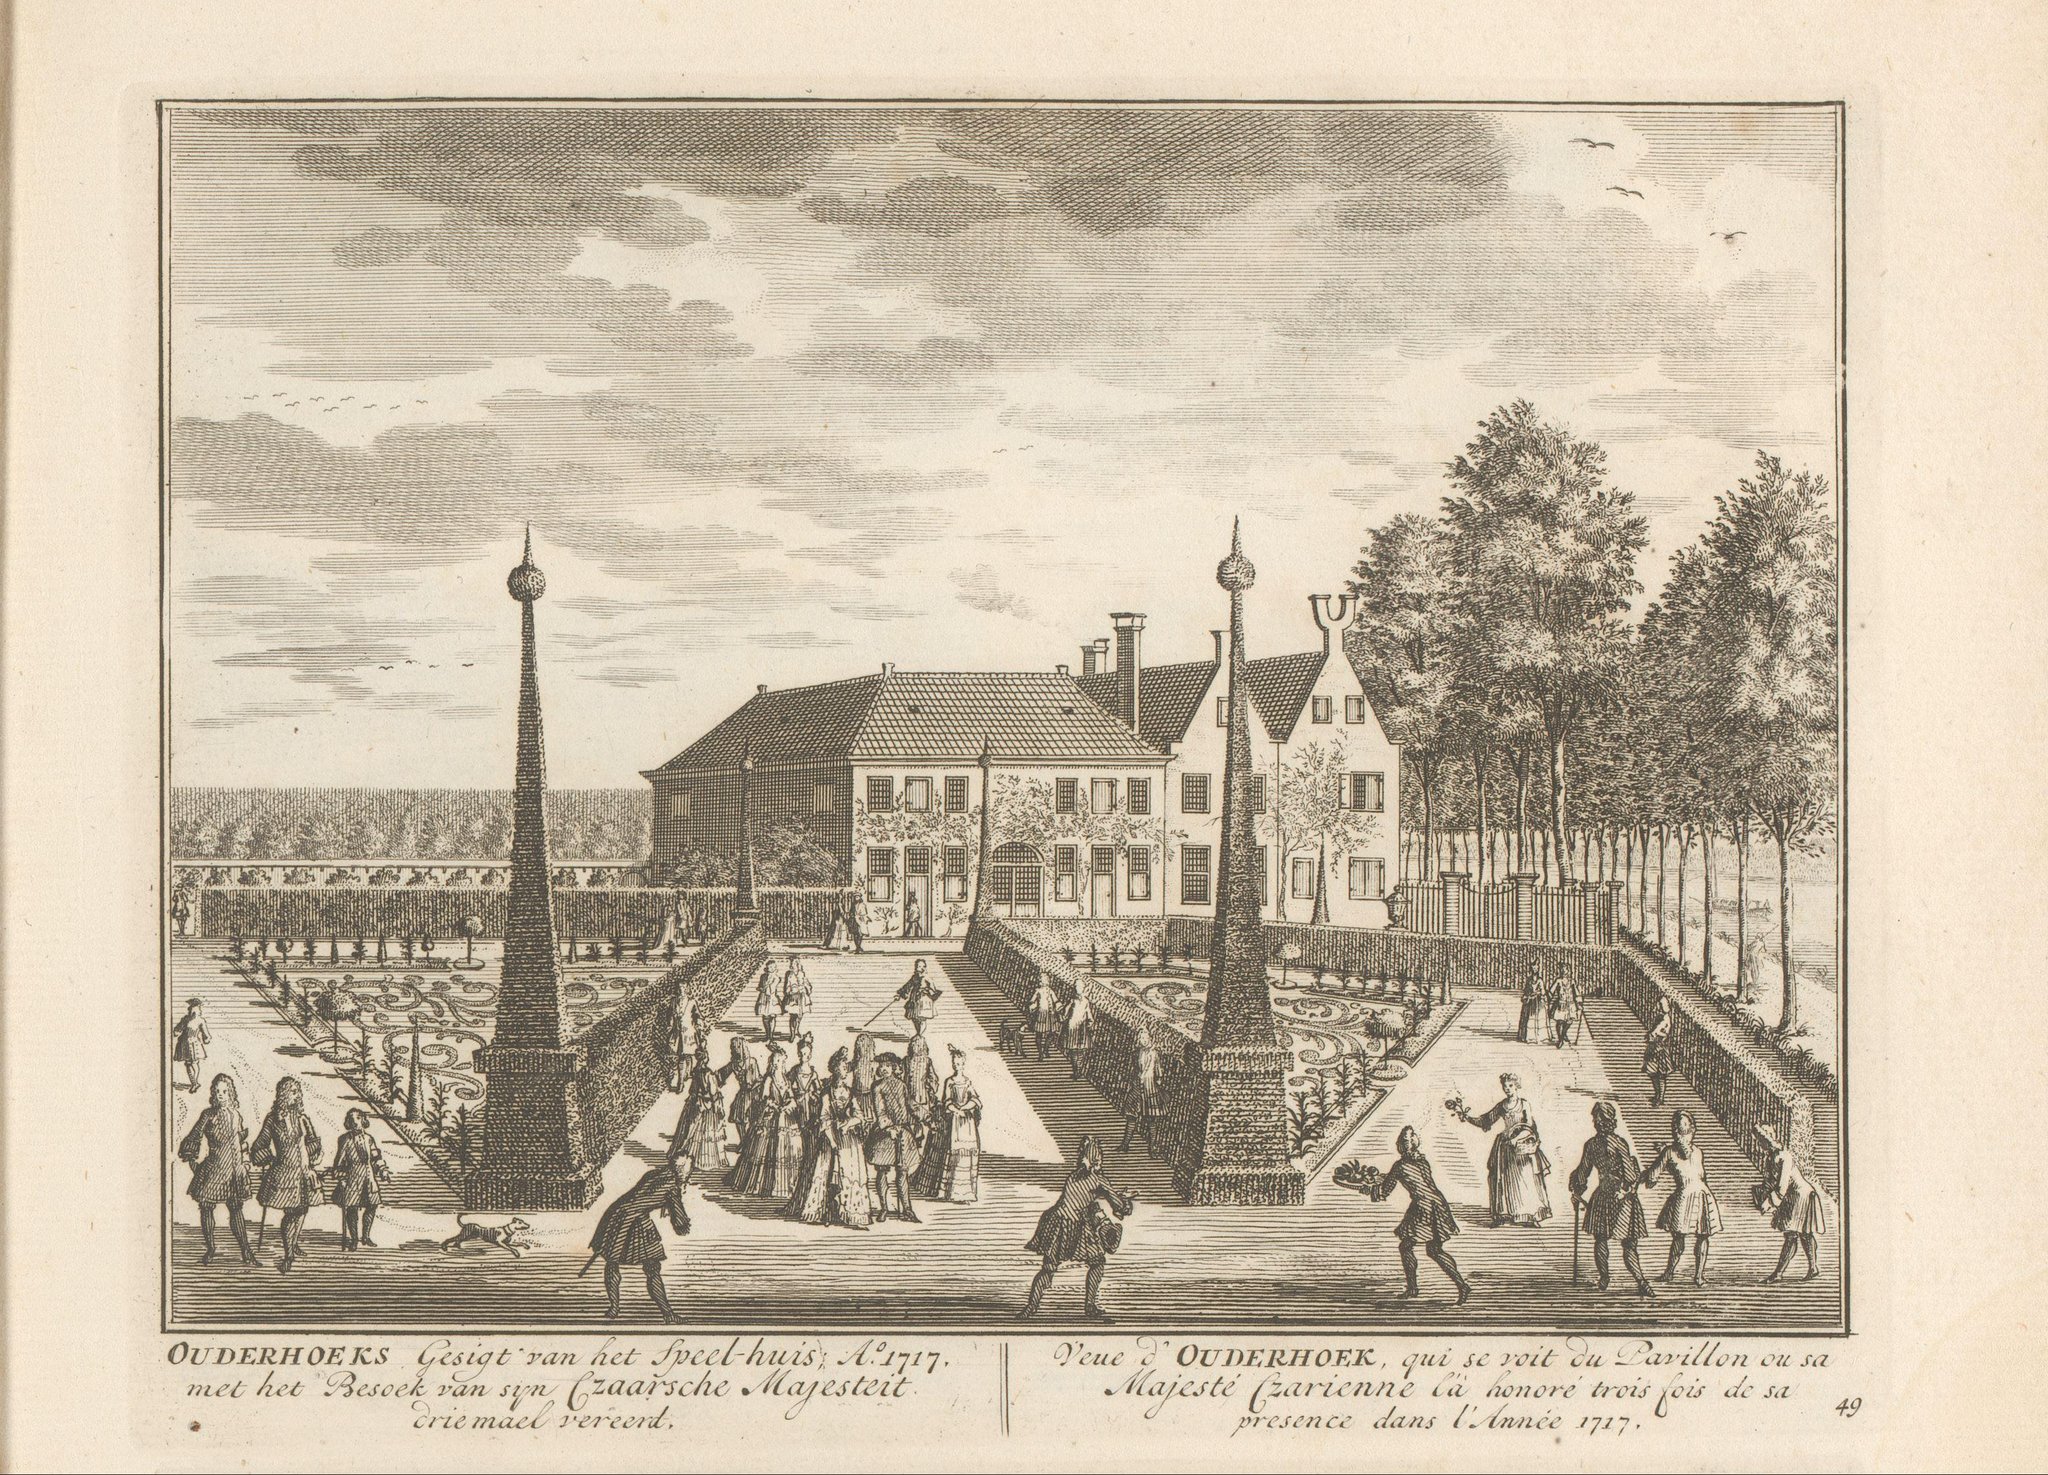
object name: book illustration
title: Ouderhoeks Geisgt van het Speel-huis A 1717 met het Besoek van syn Czaarsche Majesteit driemael vereerd / Veue d'Ouderhoek, qui se voit du Pavillon ou sa Majesté Czarienne La honoré trois fois de sa presence dans l'Année 1717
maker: daniël stopendaal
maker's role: print maker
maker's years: 1672-1726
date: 1790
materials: paper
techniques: engraving, etching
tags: visiting; receiving guests; elegant company, french or architectonic garden; formal garden, river (+ landscape with figures, staffage), country-house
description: Prent gebruikt in: Leth, Andries de. De zegepraalende Vecht, vertoonende verscheidene gesichten van lustplaatsen, heeren huysen en dorpen, beginnende van Uitrecht en met Muyden besluytende (...). Amsterdam: Weduwe Nicolaus Visscher, 1719. Prent ook gebruikt in: Brouërius van Nidek, Matthaeus. De Vechtstroom, van Utrecht tot Muiden (...). Amsterdam: H. Gartman, W. Vermandel en J.W. Smit, 1790.